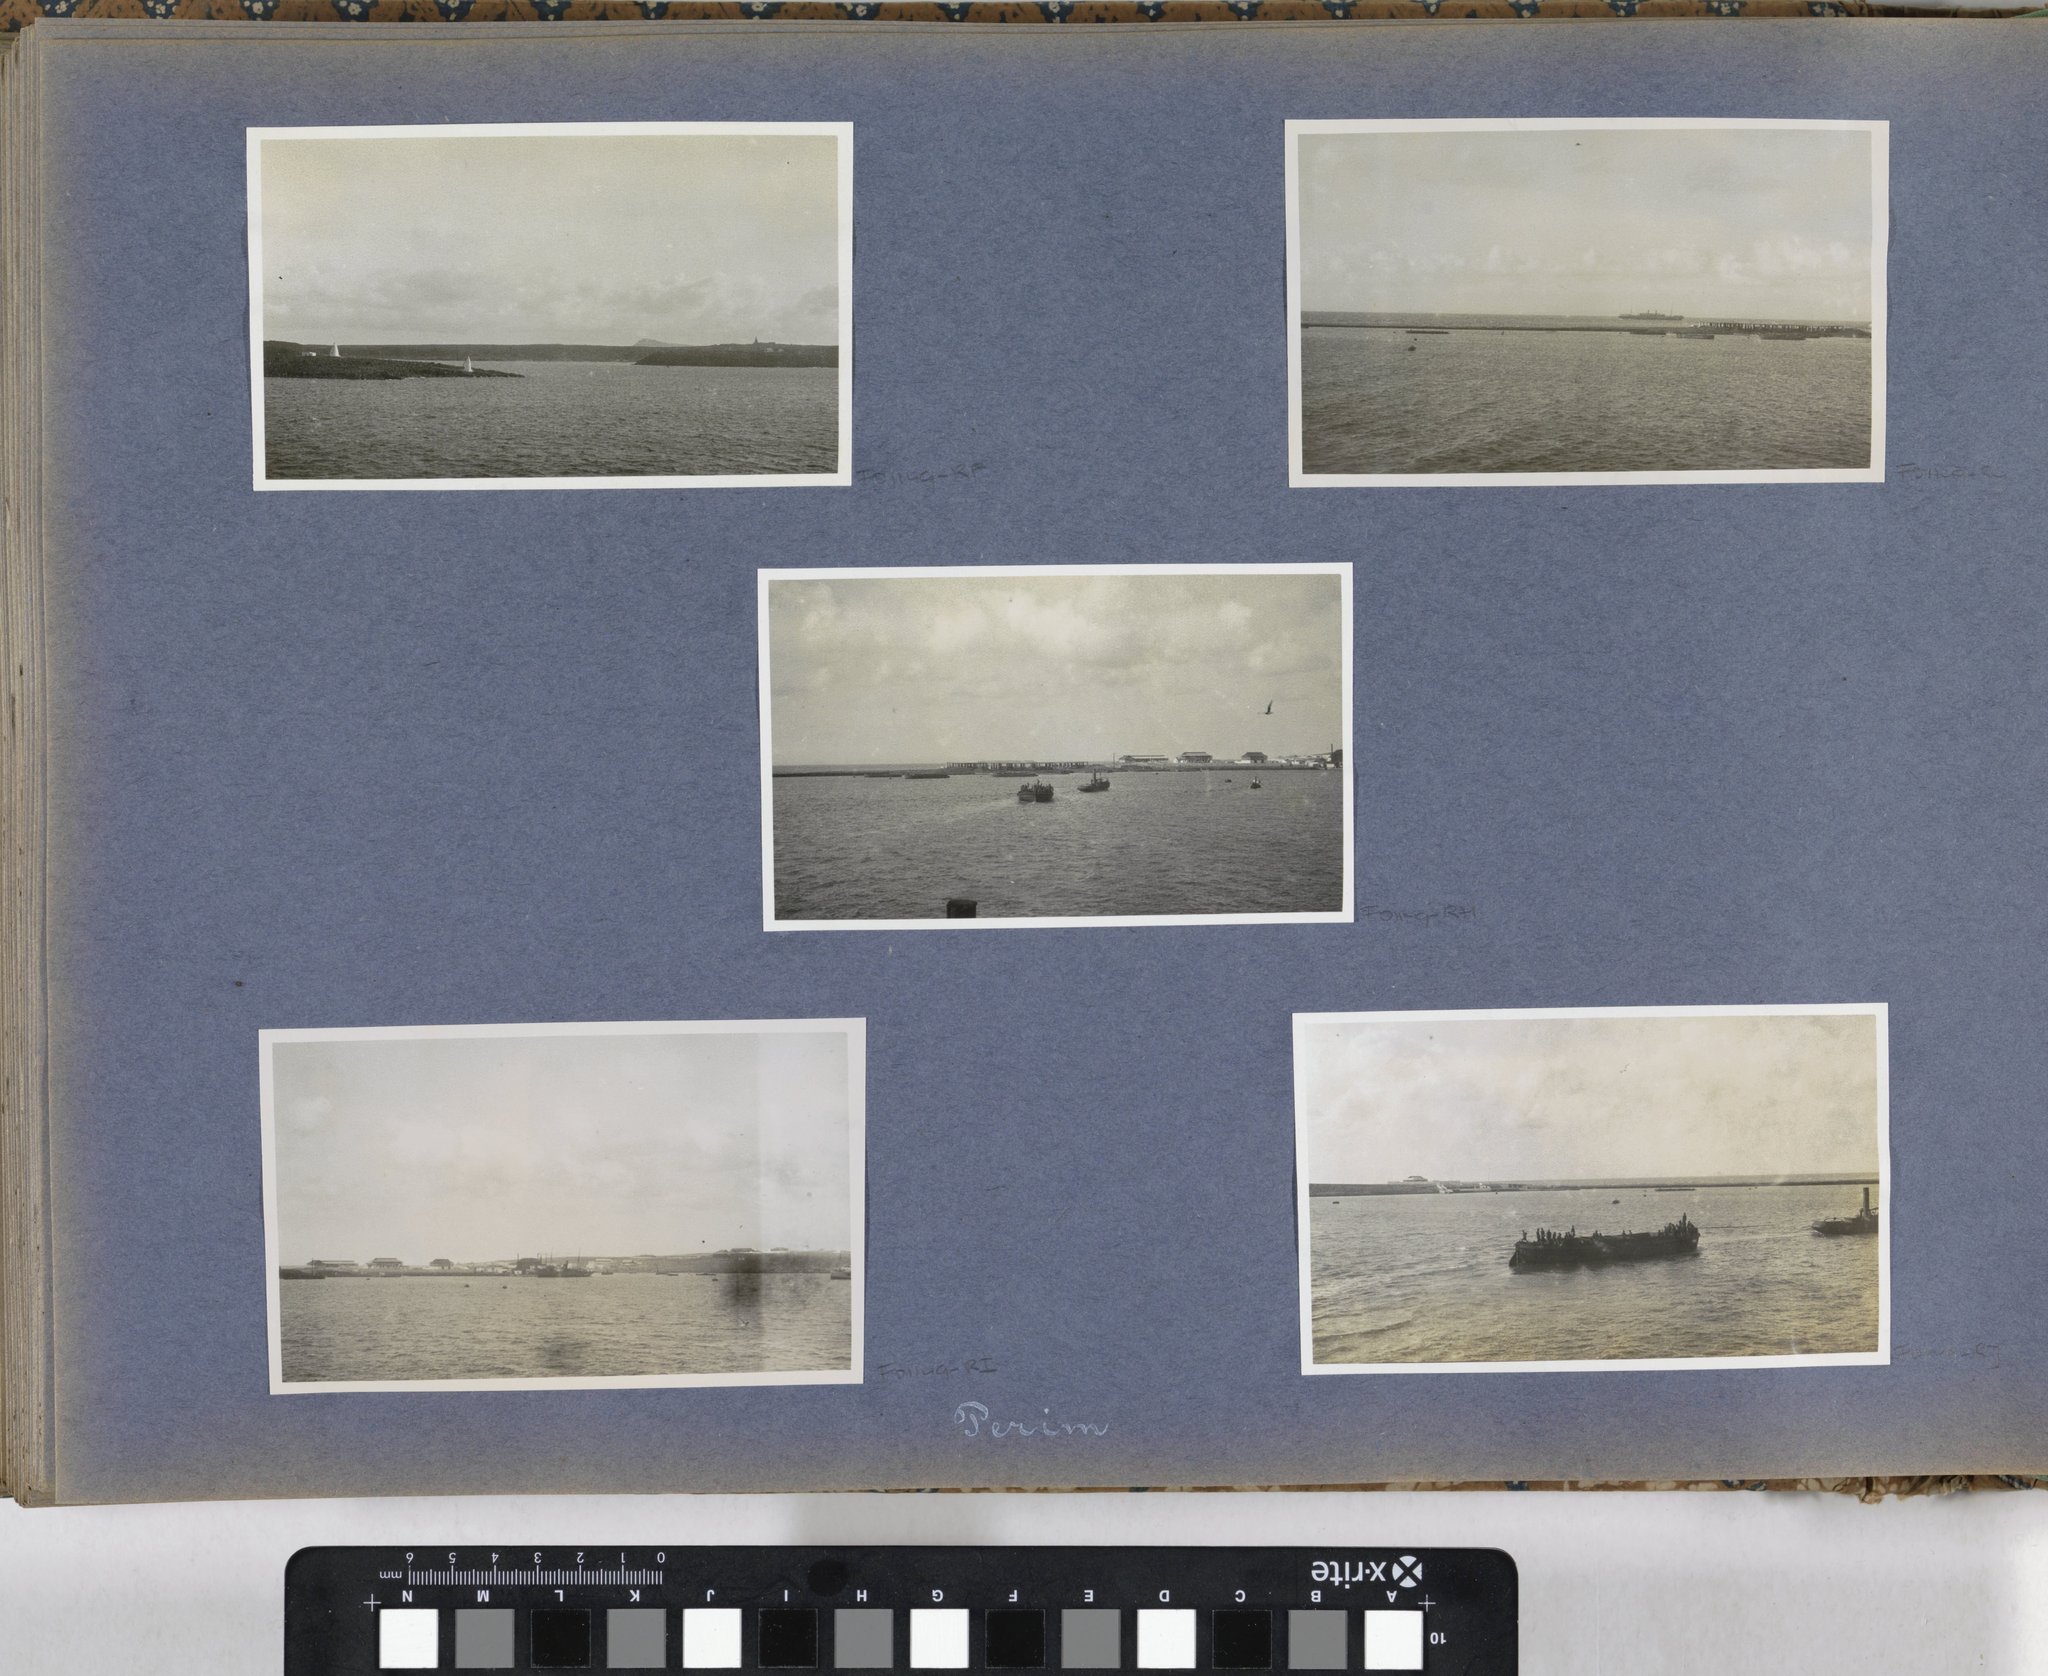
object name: photograph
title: Gezicht op de haven van Perim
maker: Anonymous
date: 1900-1920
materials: paper, photographic support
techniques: gelatin silver print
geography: perim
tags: harbour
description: Onderdeel van reisalbum met foto's van bedrijvigheid en bezienswaardigheden op Sumatra en Java en van de reis naar en van Nederlands-Indië.